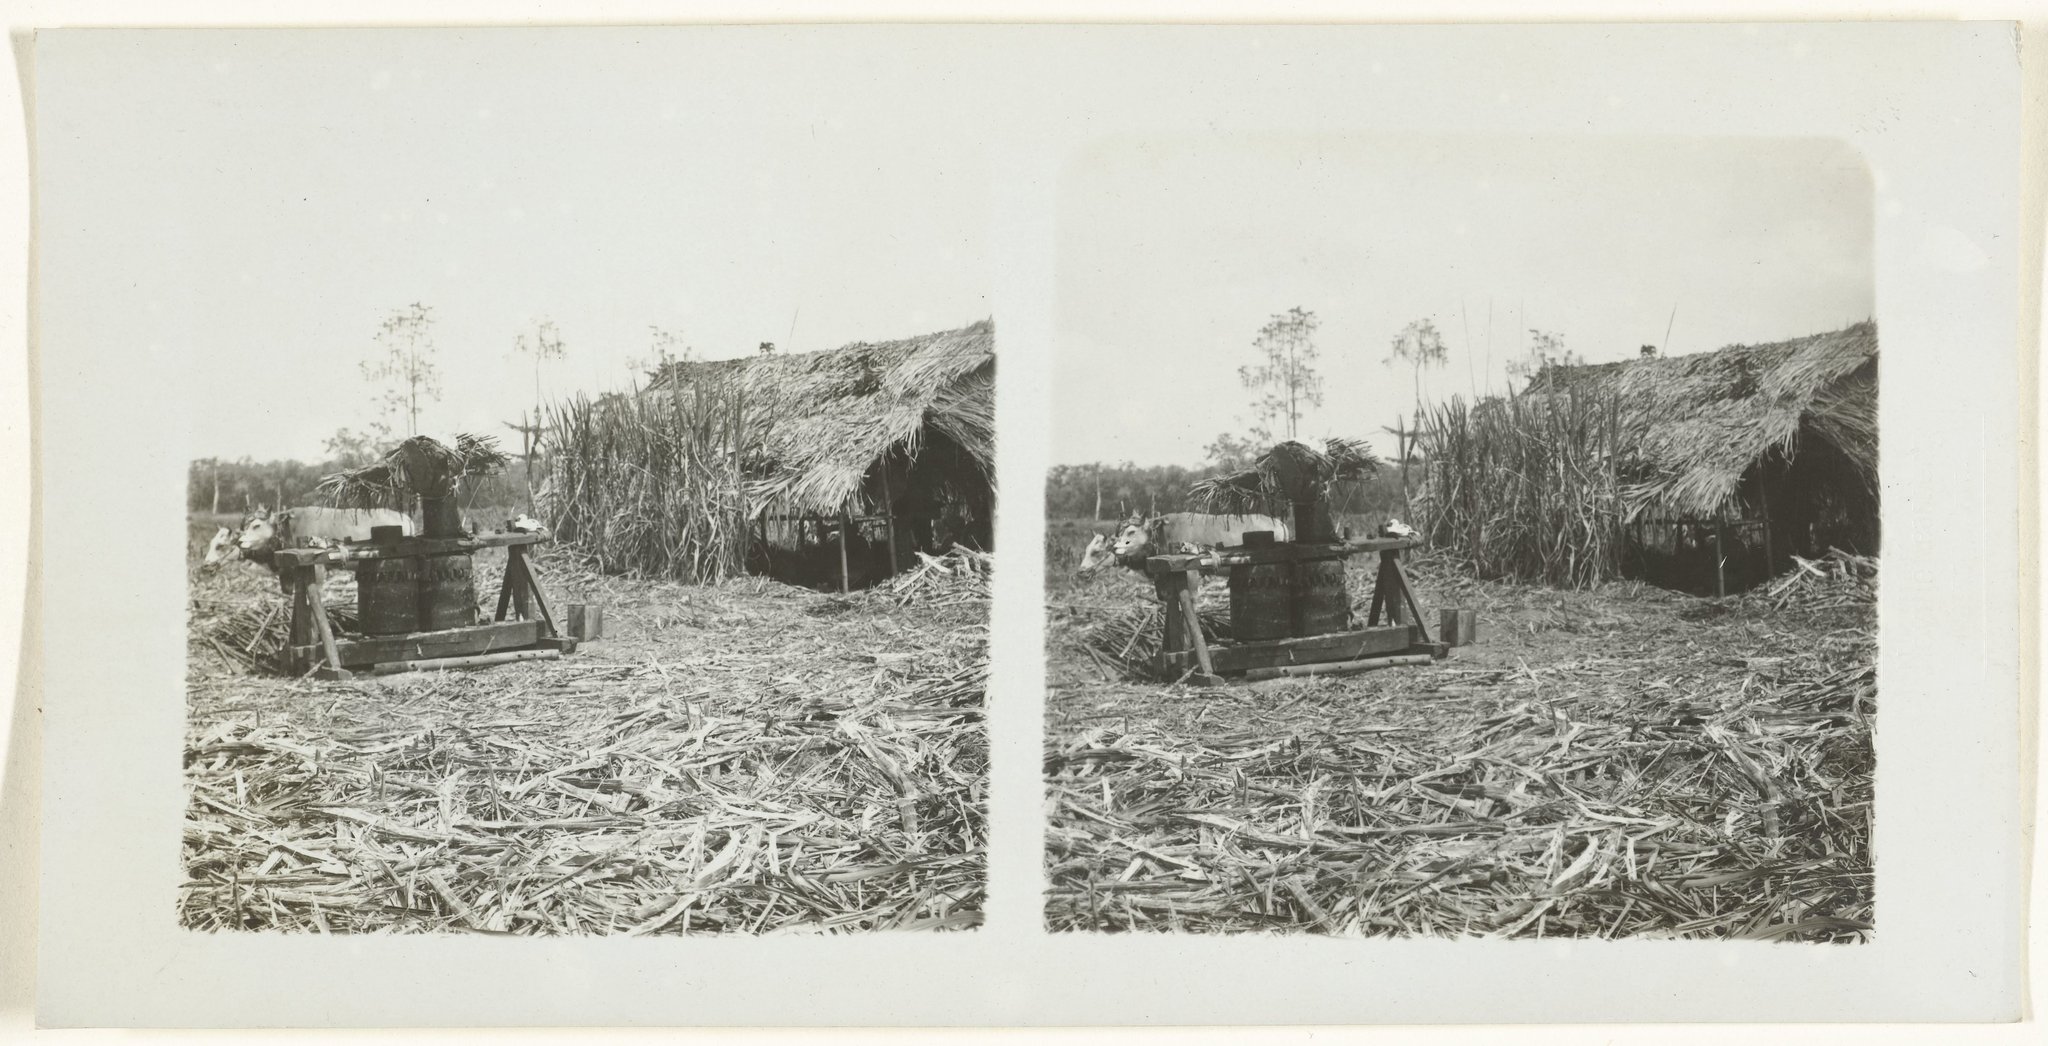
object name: photograph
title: S 9 No 99. Een inl. suikerrietmolen.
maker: neville keasberry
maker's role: fotograaf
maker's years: 1866-1944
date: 1900-1935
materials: cardboard, paper, photographic support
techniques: albumen print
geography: malang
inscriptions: signature: ‘Neville Keasberry, Malang (Java)’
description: Een suikerrietmolen in een veld met daarachter twee runderen. De molen moet met de hand worden voortbewogen.